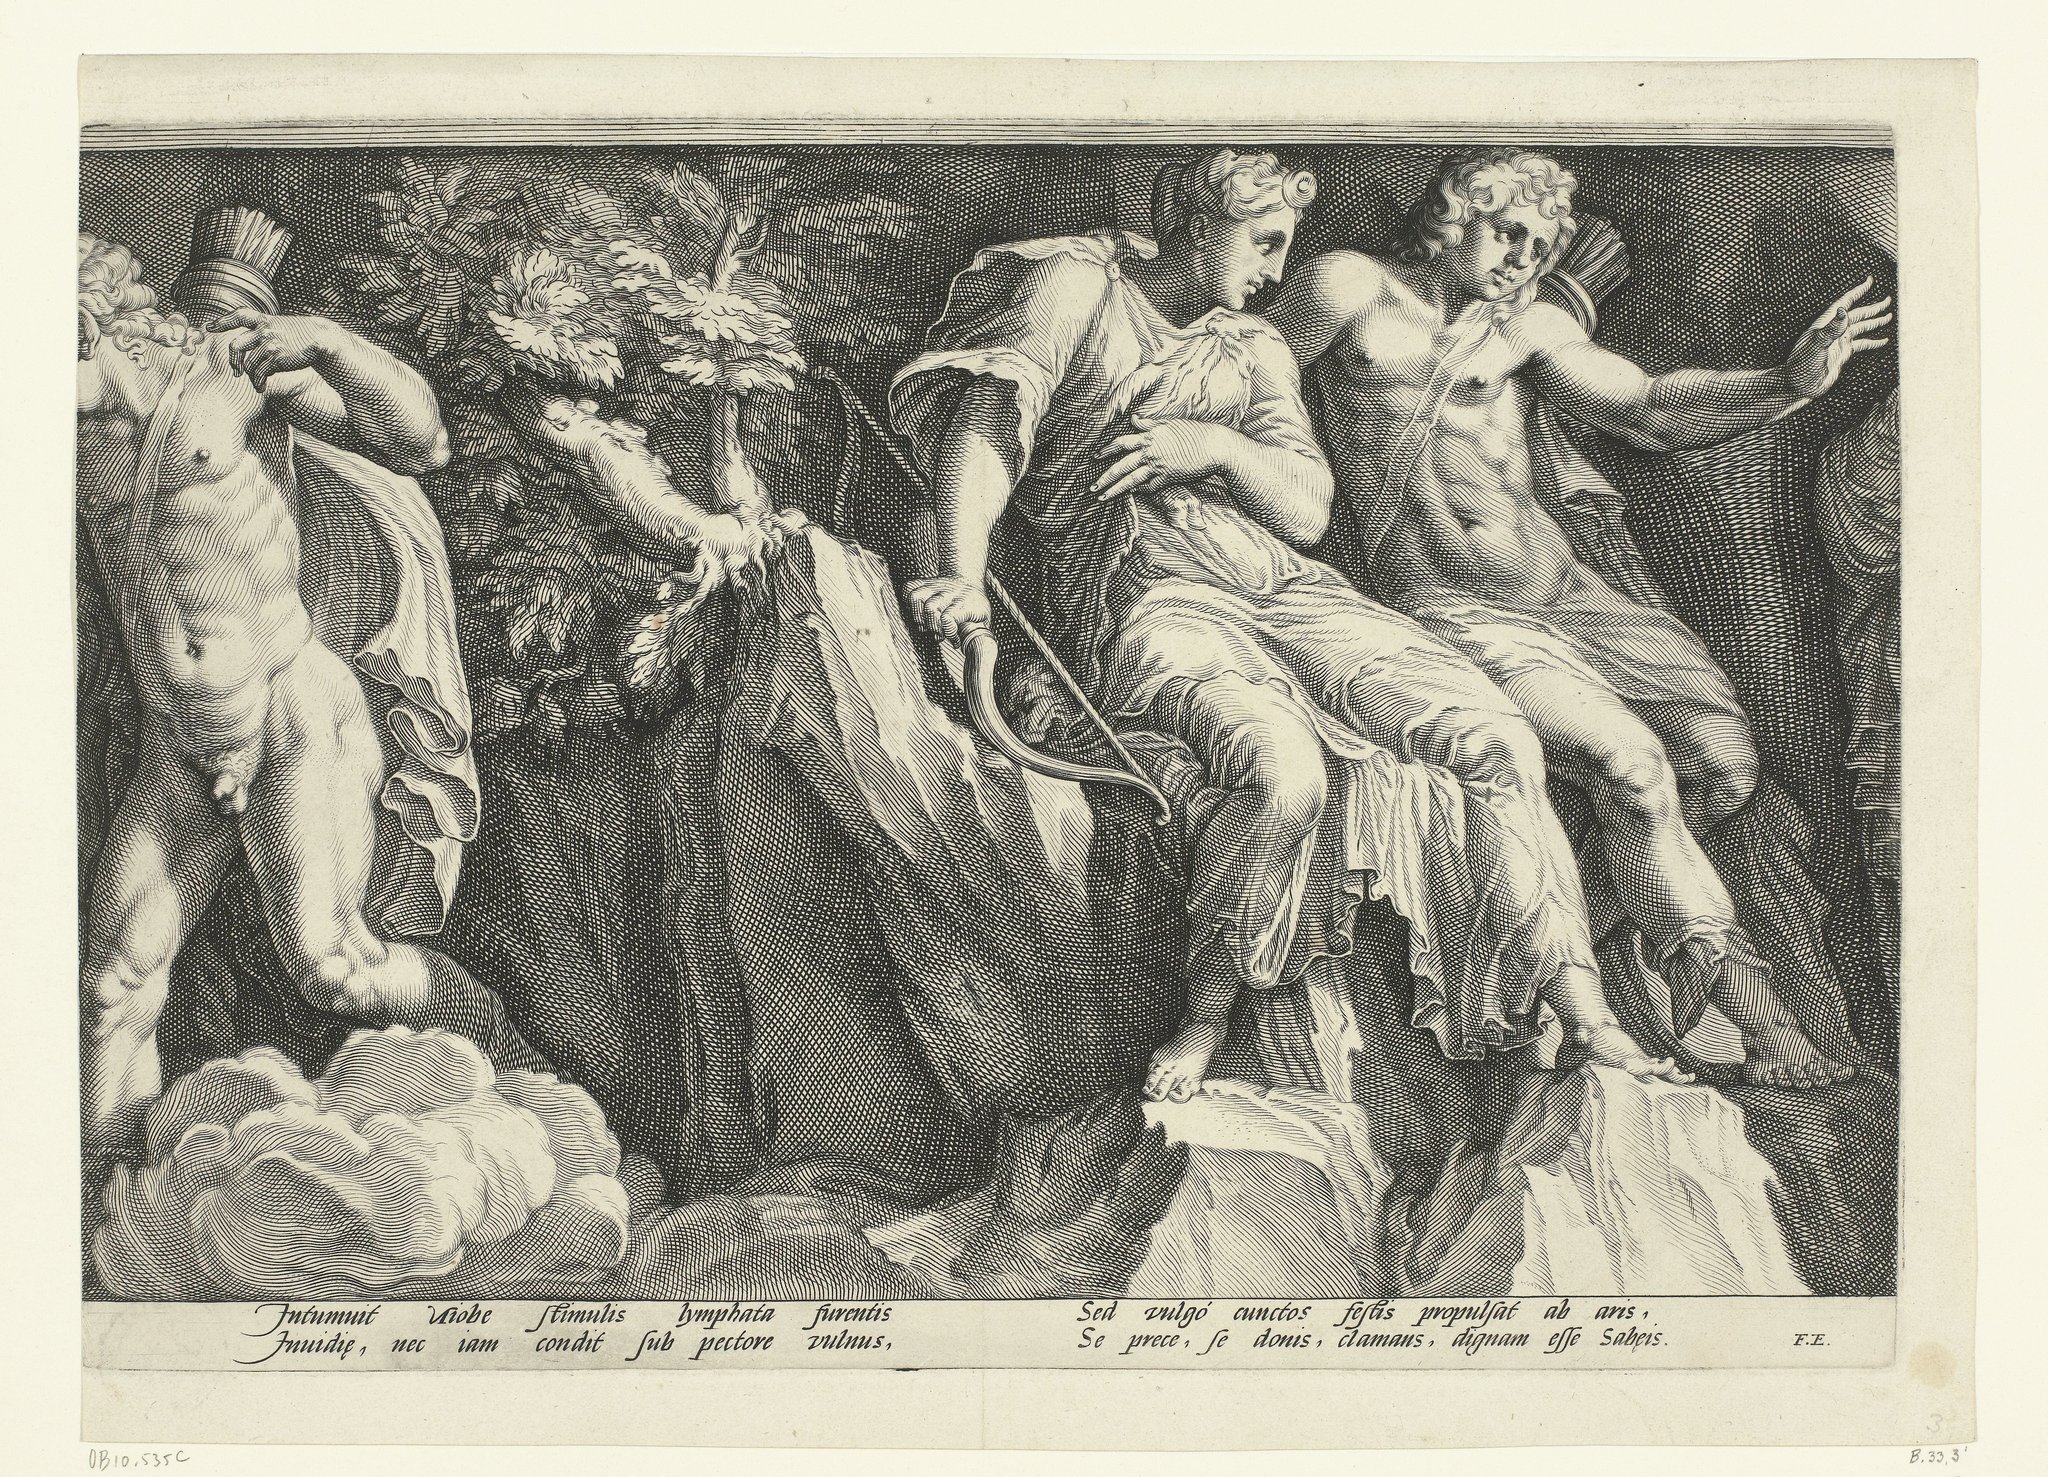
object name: print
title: Fries met de bestraffing van Niobe (plaat 3)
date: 1594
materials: paper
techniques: engraving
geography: haarlem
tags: latona entreats her children apollo and diana to punish niobe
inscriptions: collector's mark: Lugt 240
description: De godin Latona doet haar beklag bij haar twee kinderen, Apollo en Diana die vervolgens haar eer wreken door de veertien kinderen van Niobe te doden met pijlen. De prent heeft een Latijnse onderschrift. Linke rplaat van een prent met een fries uit acht platen